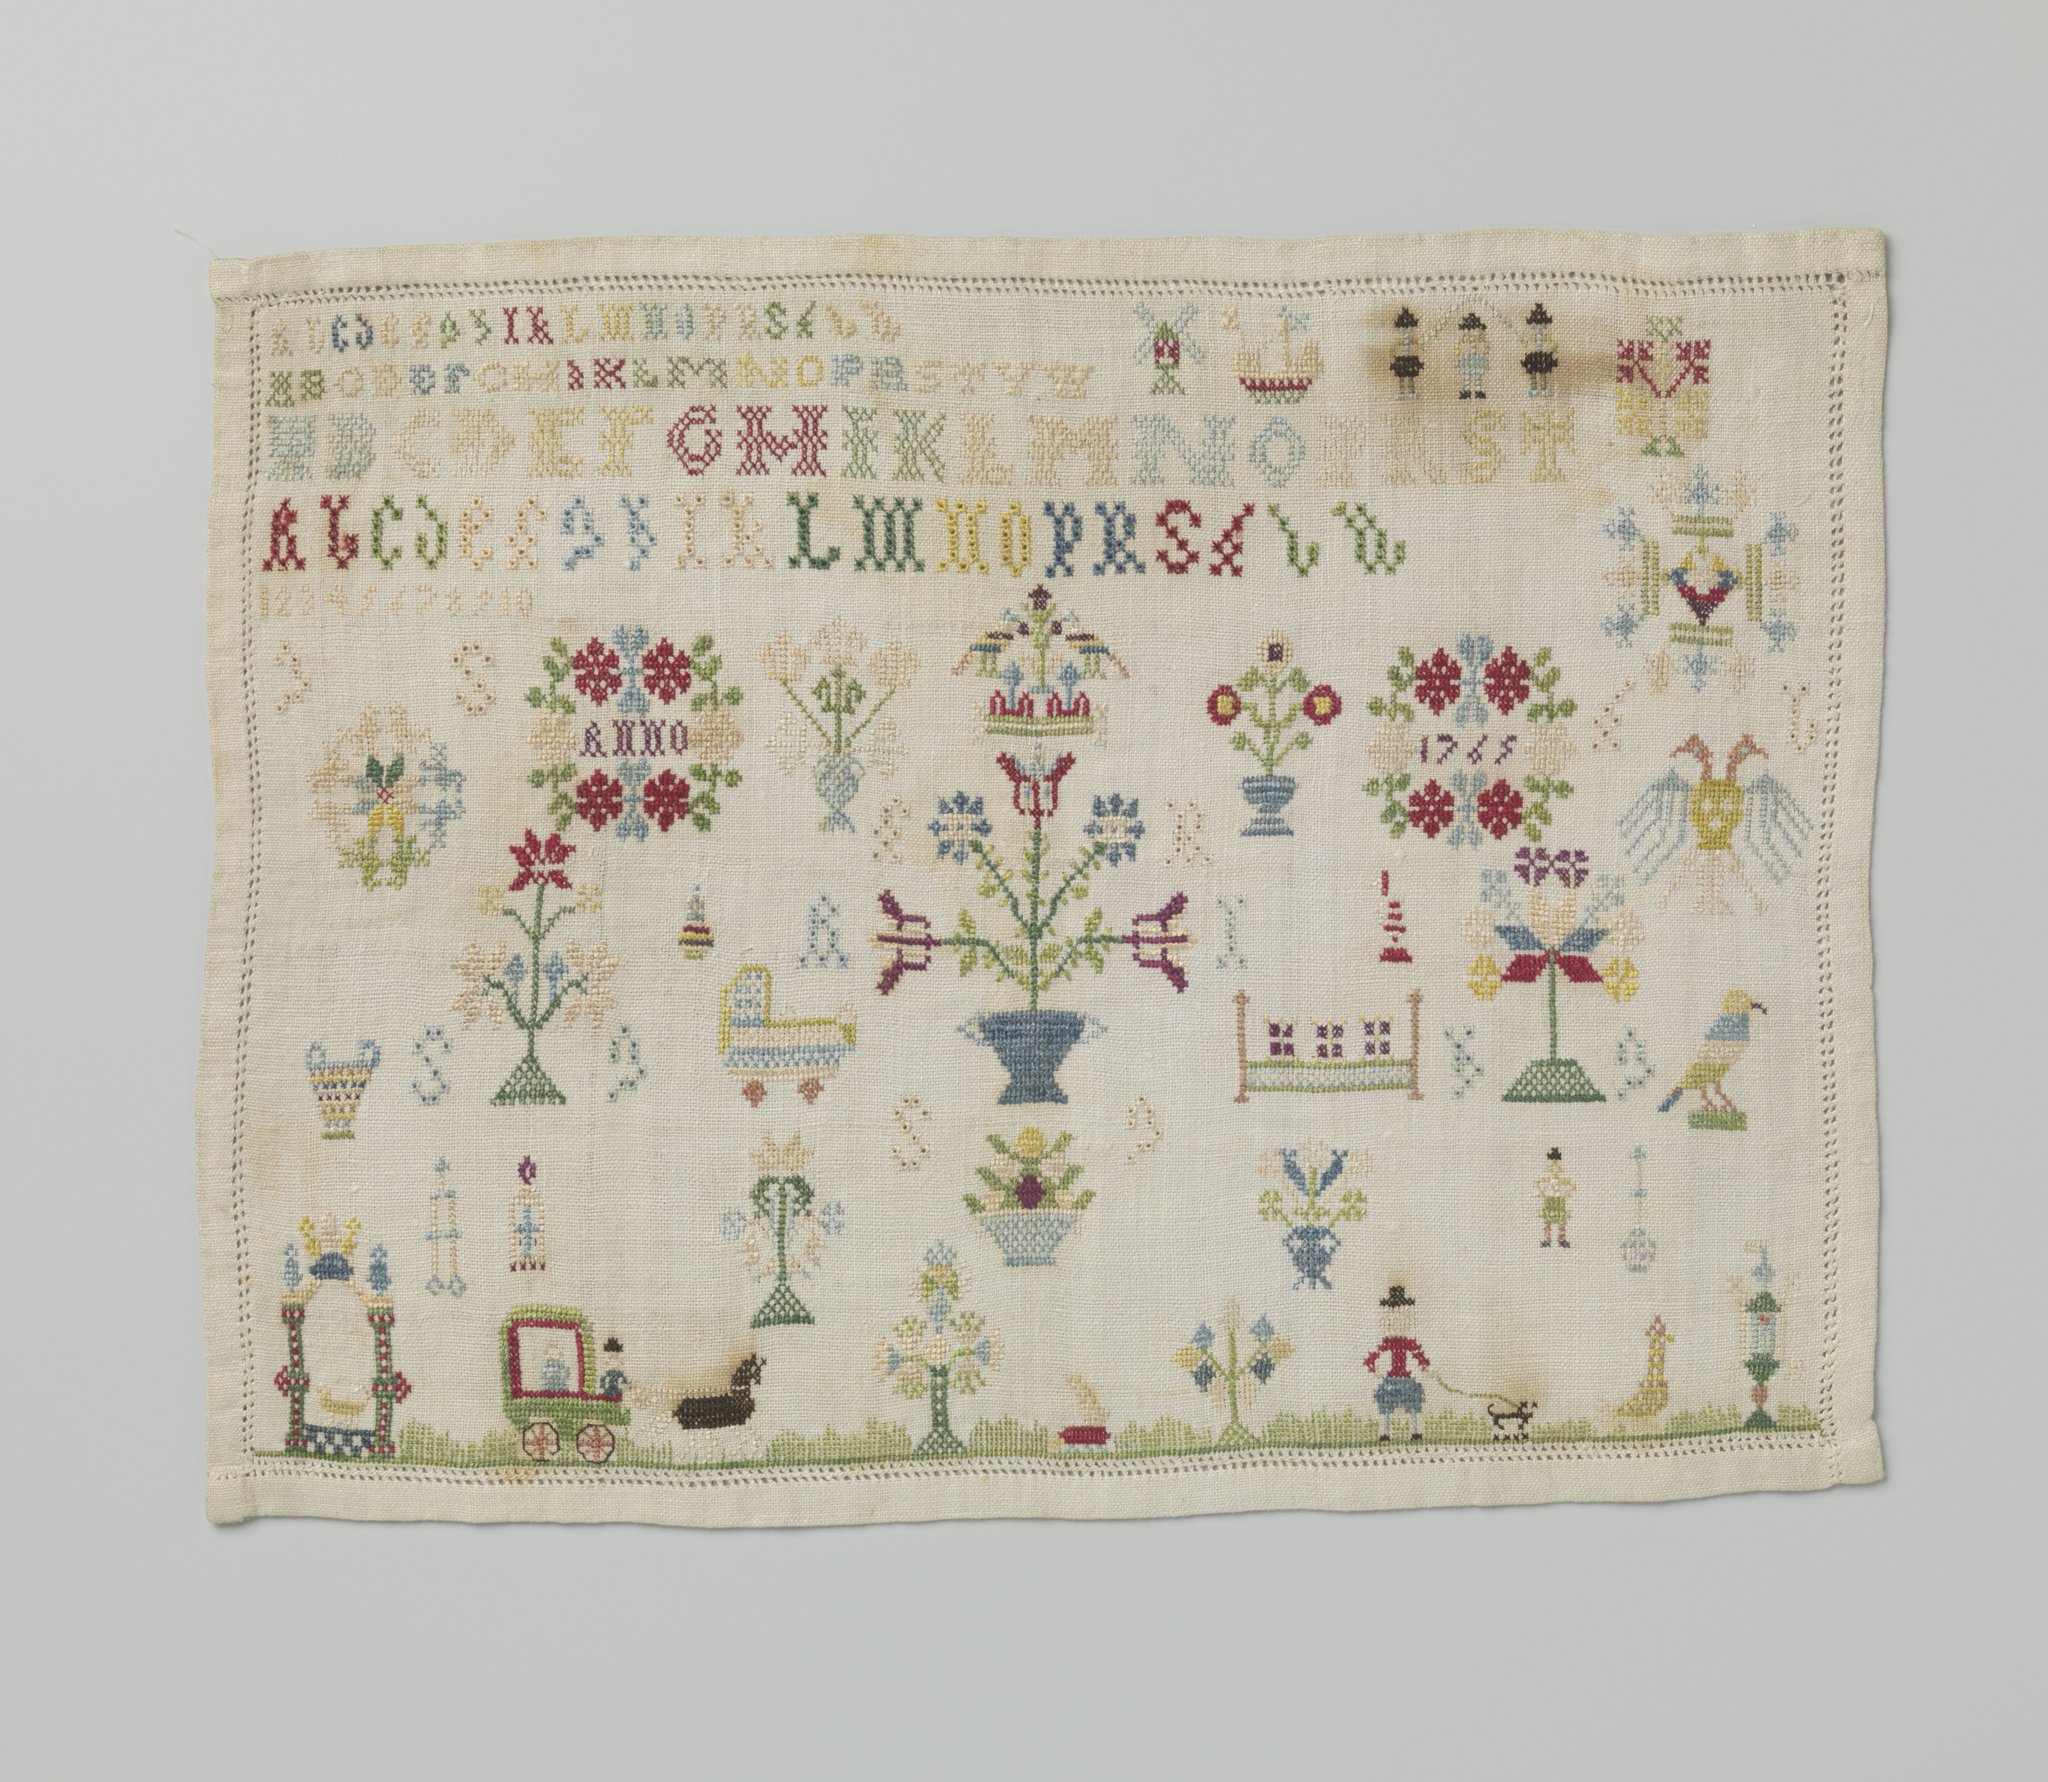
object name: merkdoek, merklap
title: Merklap van veelkleurige zijde op linnen.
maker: Anonymous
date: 1765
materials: linen, silk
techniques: embroidered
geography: groningen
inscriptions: date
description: Merklap van zijde op linnen. Het borduurwerk heeft het jaartal ANNO 1765, de initialen GS, TB, KR, AI, SE, HG en SG. Het borduurwerk heeft bovendien letter- en cijferoefeningen en diverse stoppen, waaronder vogels, een wieg, een bed, een man met een hond en een molen.